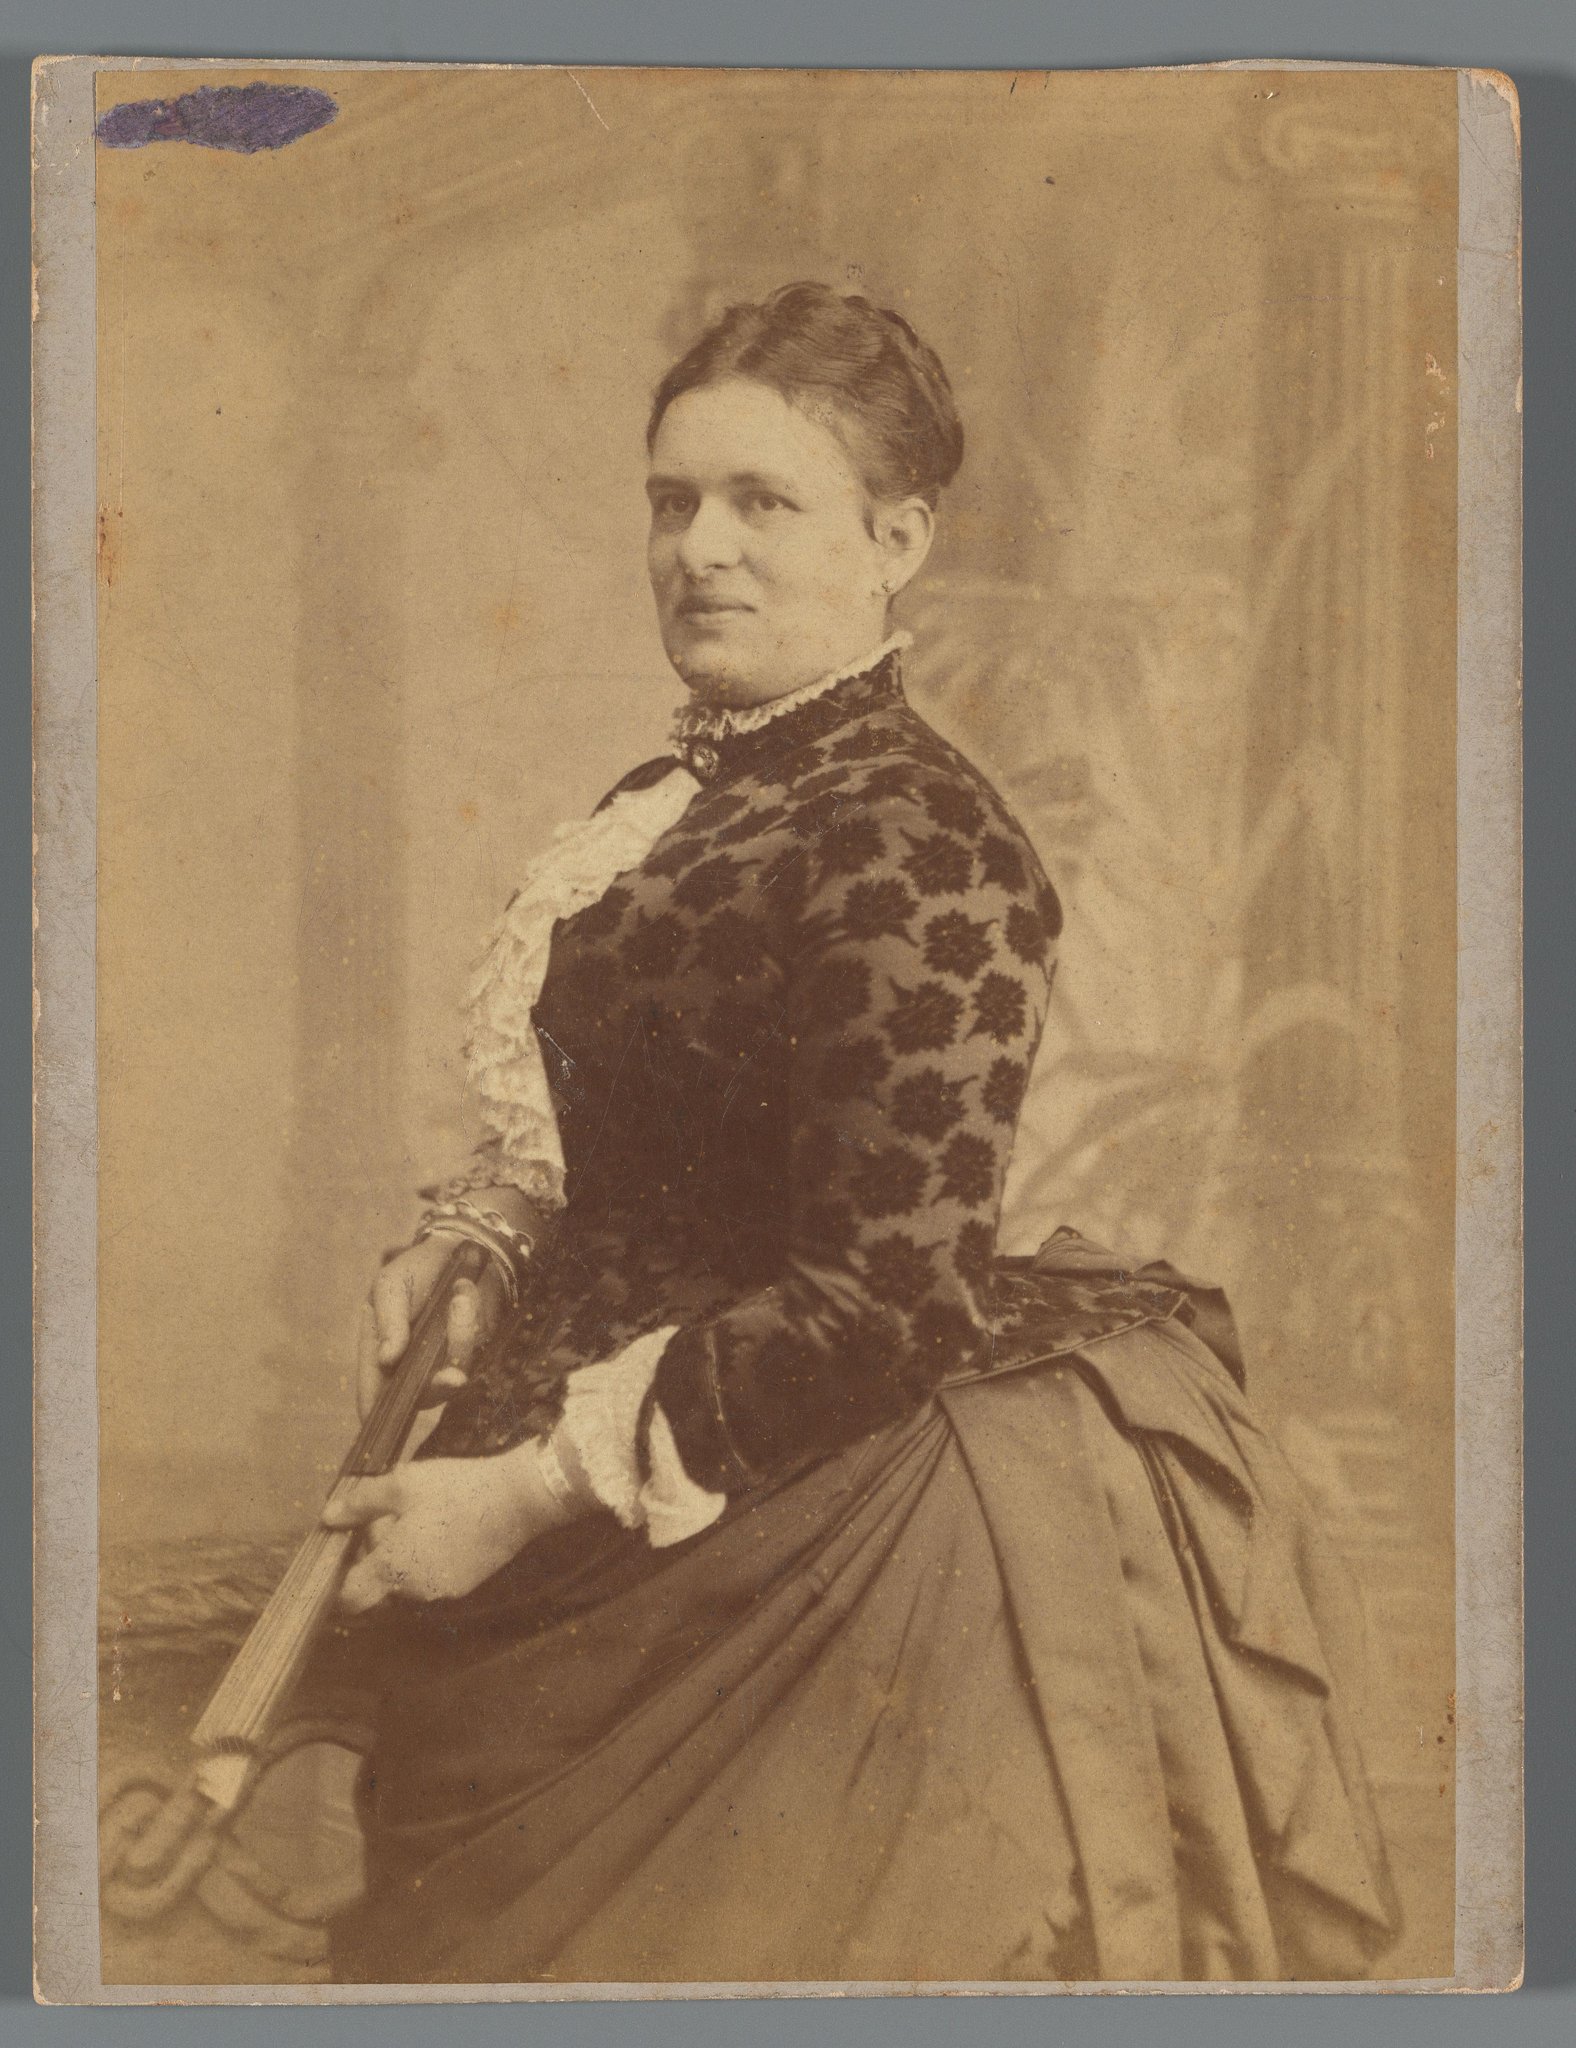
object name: cabinet photograph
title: Studioportret van Francina Schas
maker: johannes ephraim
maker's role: fotograaf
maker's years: 1838-1921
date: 1810-1884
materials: cardboard, photographic support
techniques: albumen print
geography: arnhem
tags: francina schas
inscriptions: name, name: ‘Francoise v. d. Berg / in Oct. 84.’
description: Studioportret van staande Francina Schas met gesloten waaier in handen.